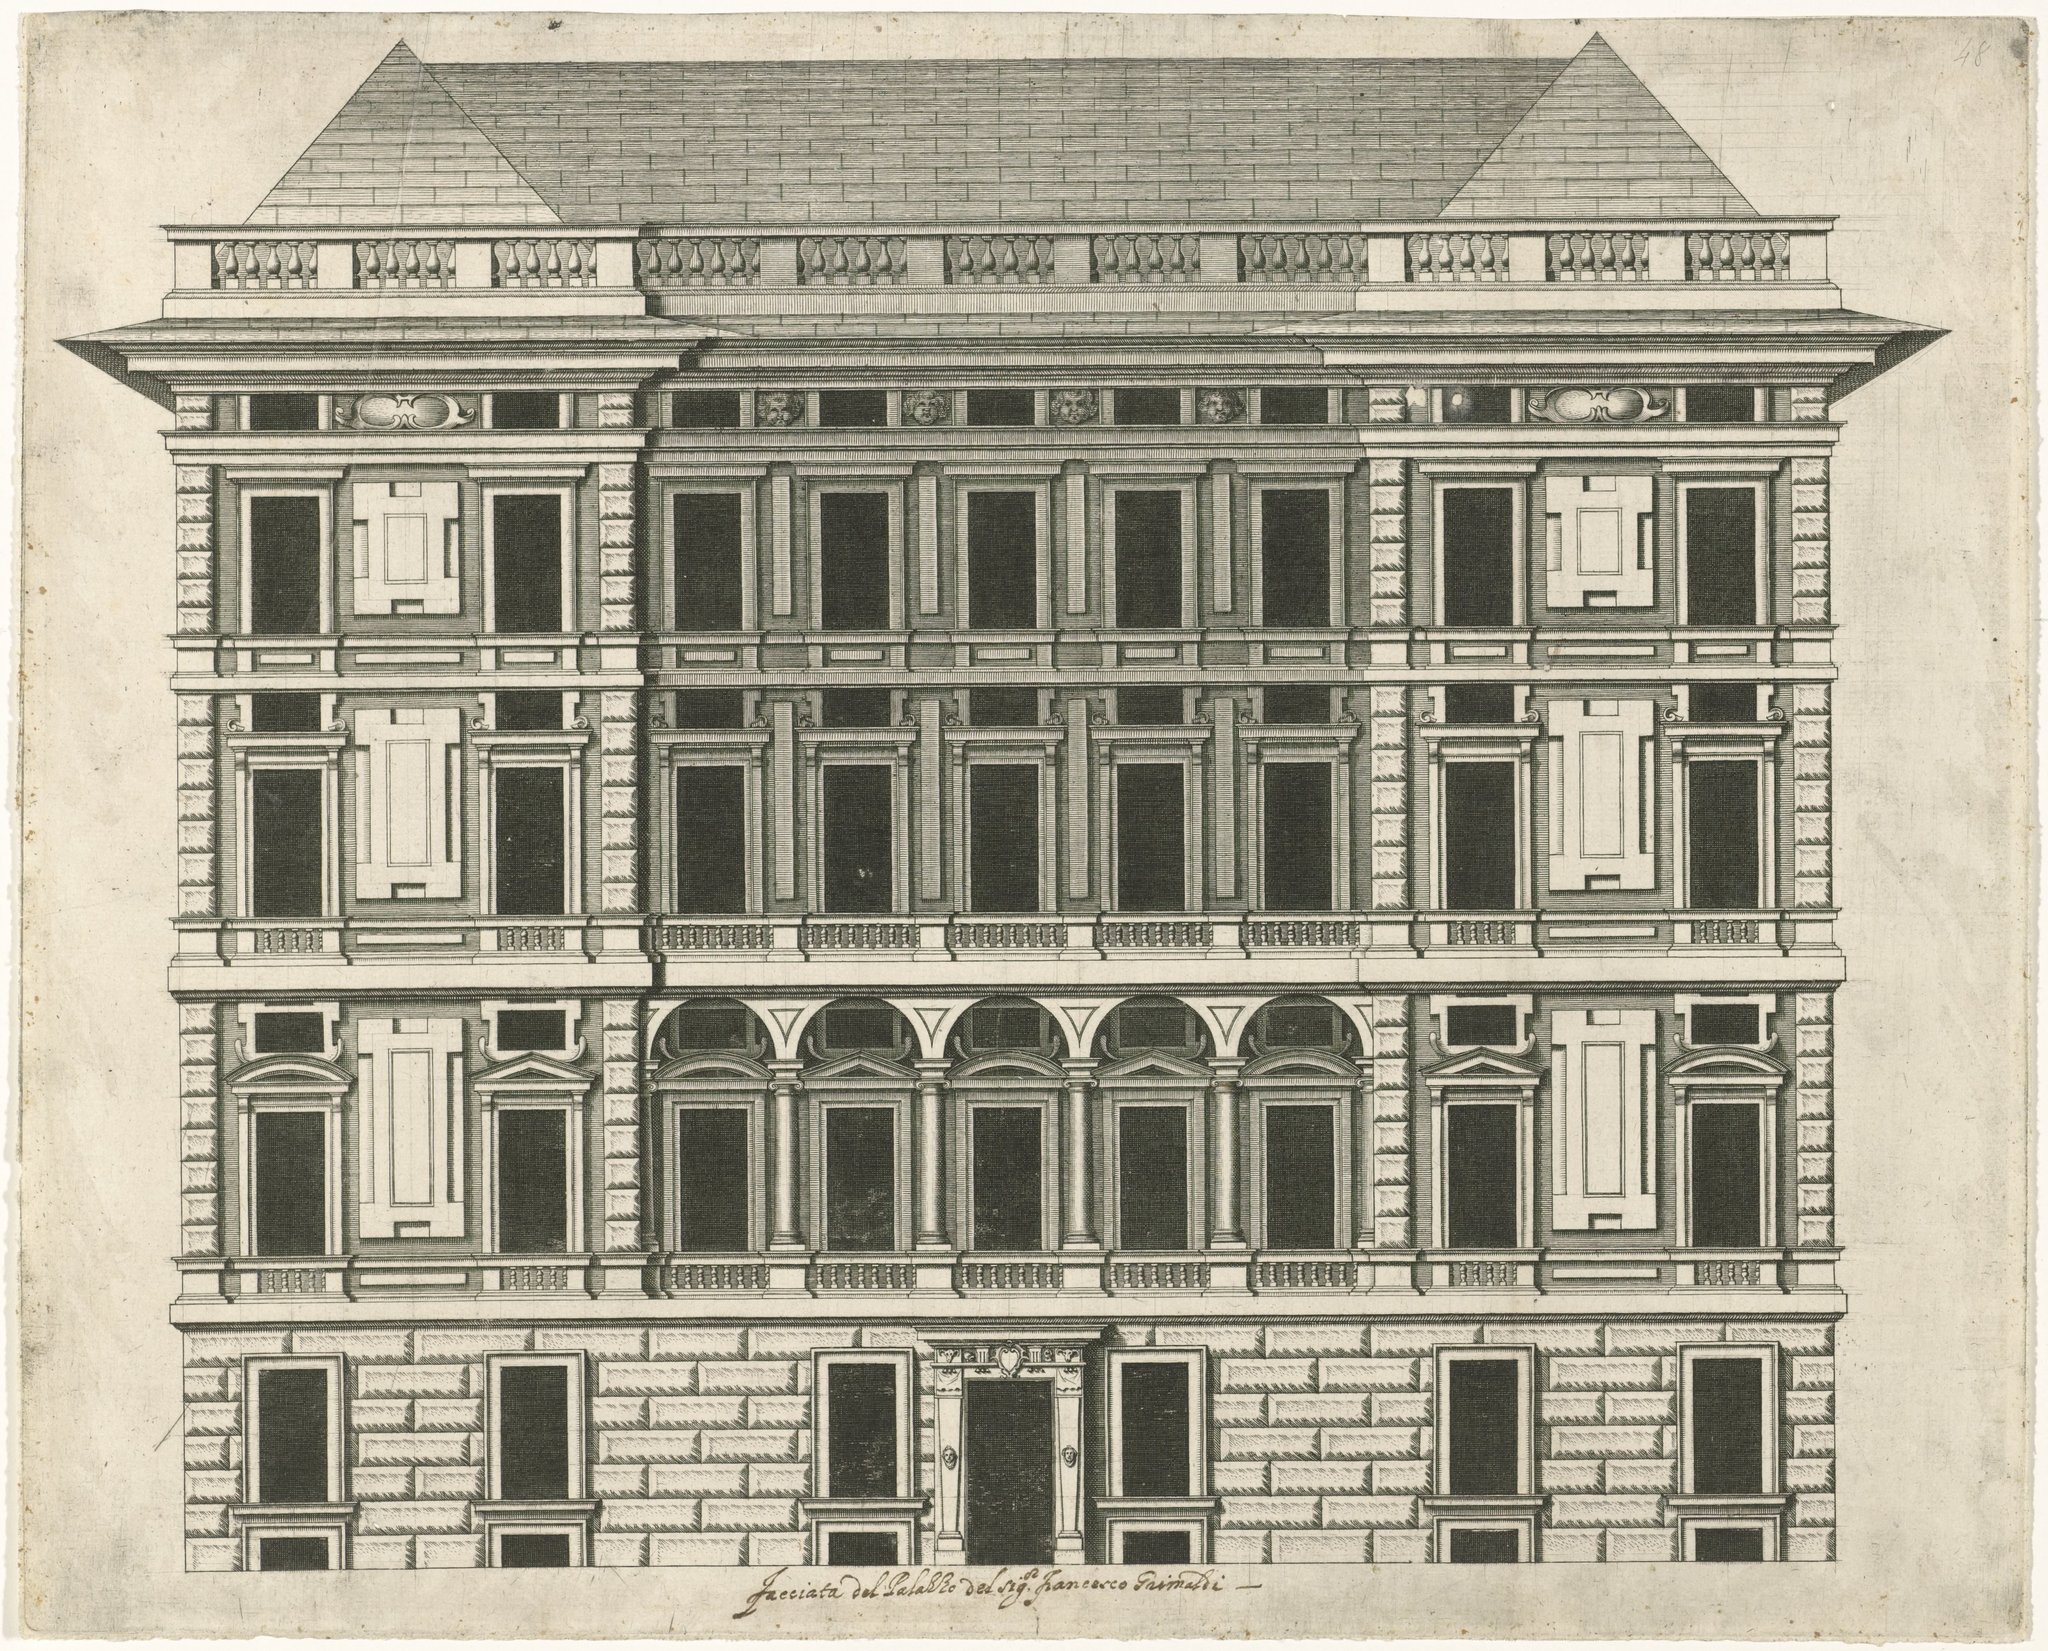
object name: print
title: Palazzo Spinola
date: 1622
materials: paper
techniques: engraving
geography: antwerp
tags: façade (of house or building)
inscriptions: inscription: ‘Facciata del Palazzo del Sig Francesco Grimaldo -’, collector's mark: Lugt 240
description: Prent gebruikt in: Peter Paul Rubens, Nicolaes Ryckmans. Palazzi di Genova. 2 dl. G. Meursio: Antwerpen, 1622, nr. 48.